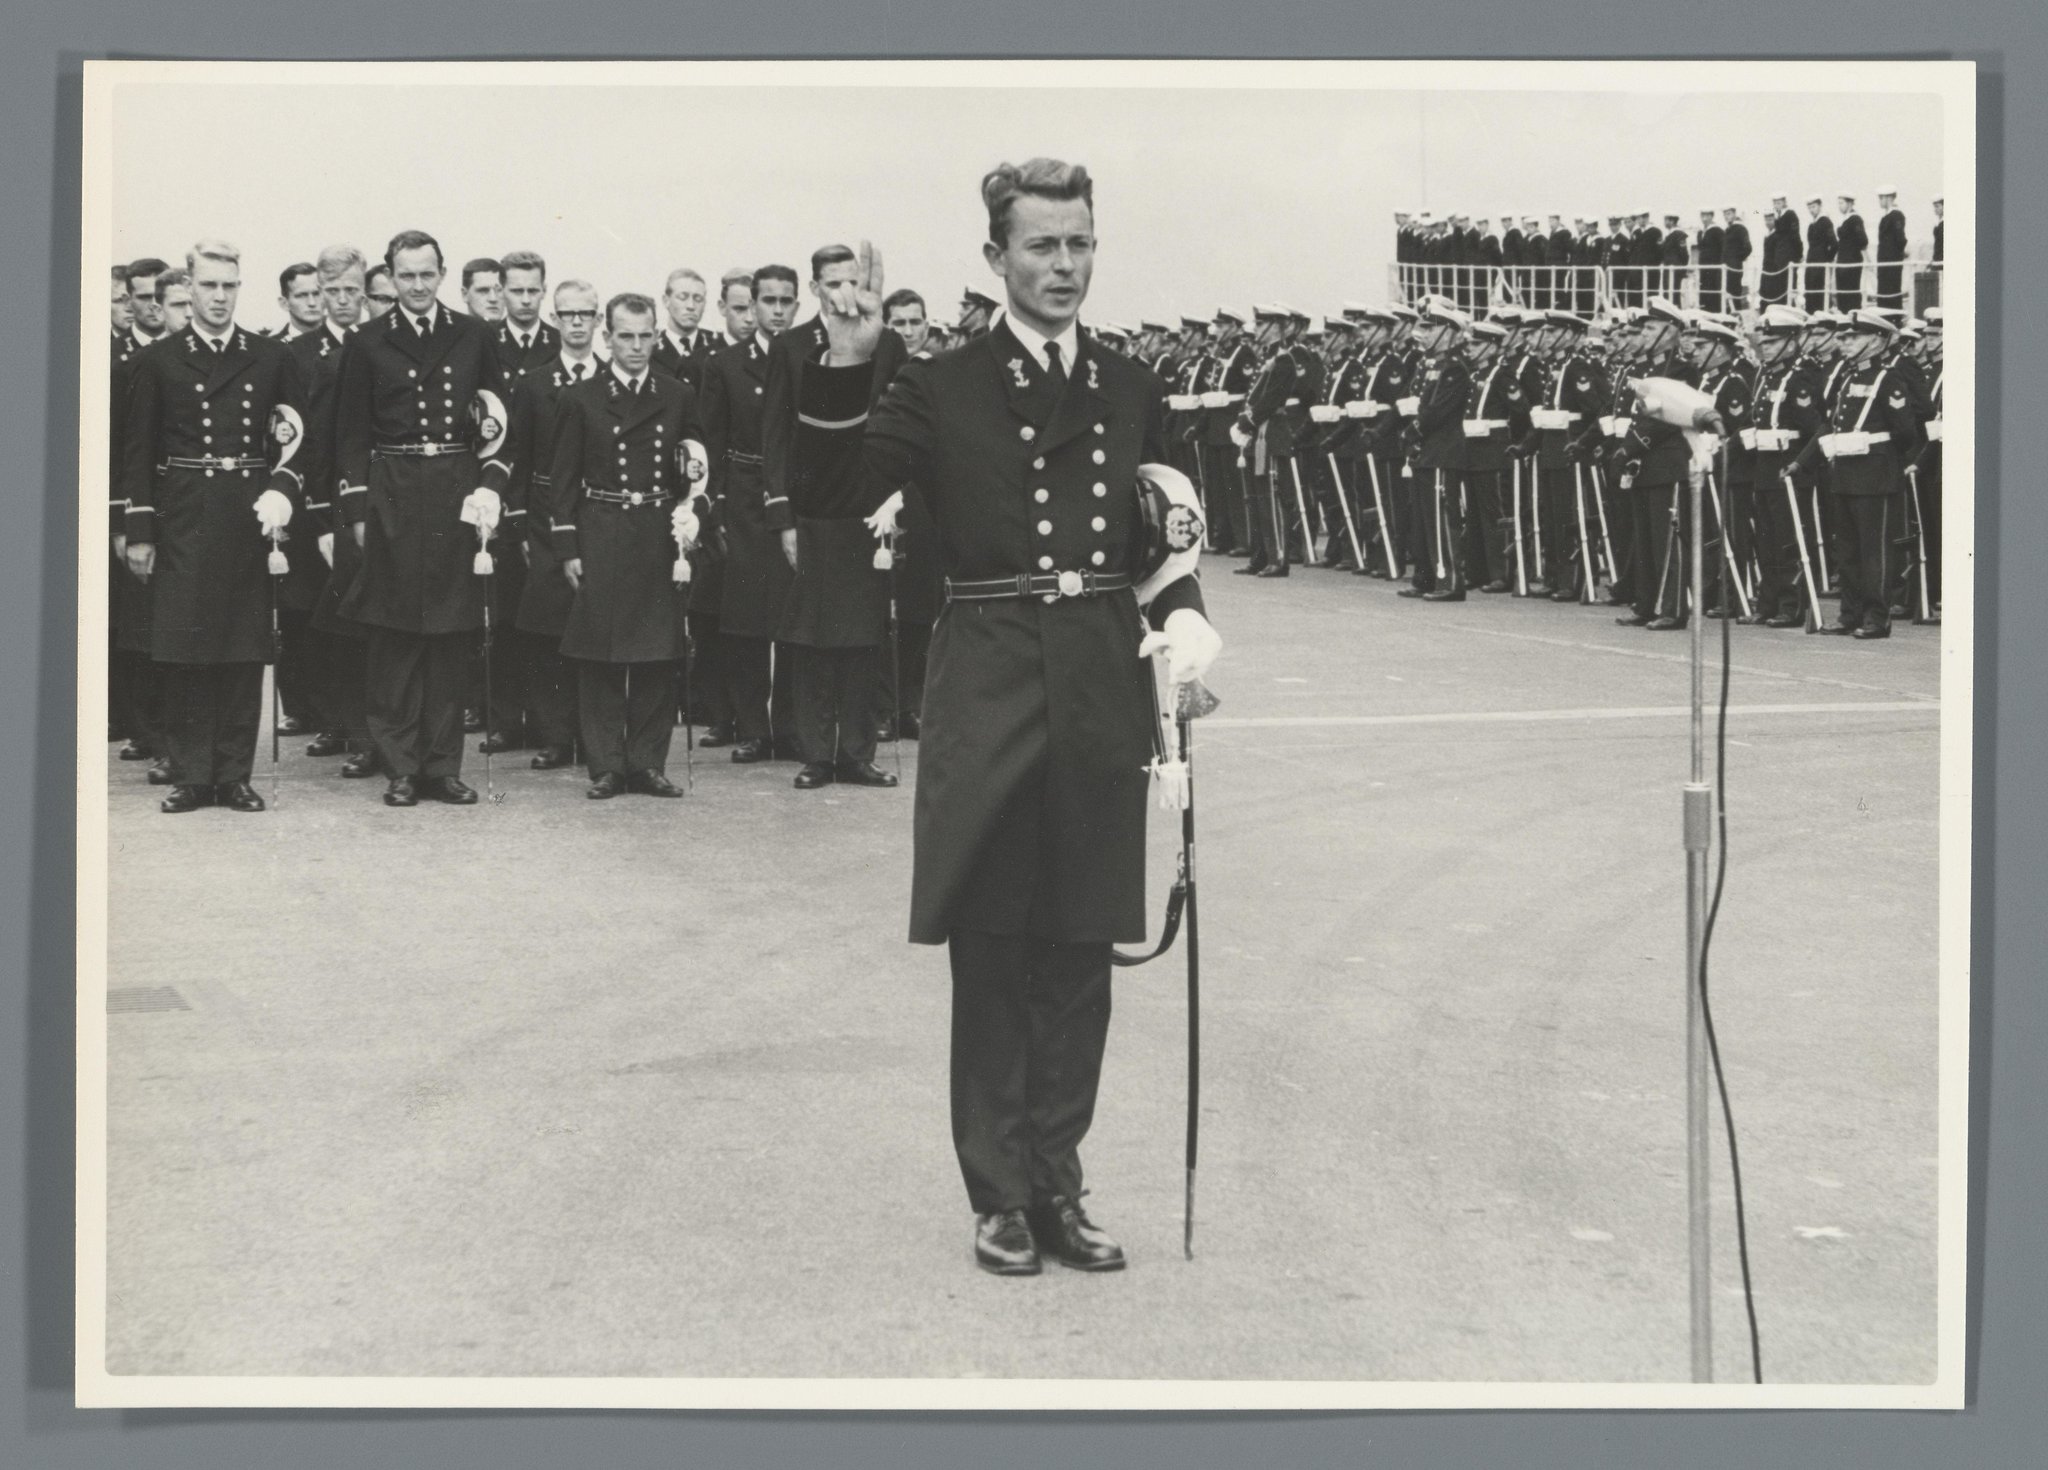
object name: photograph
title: Eedaflegginng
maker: Anonymous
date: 1965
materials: photographic support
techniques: gelatin silver print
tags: delft, historical persons, officer (+ naval force), swearing an oath (with two fingers raised)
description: Een officier van de Koninklijke Marine legt de eed af tijdens een militaire ceremonie. Waarschijnlijk een lid van de familie Swellengrebel.